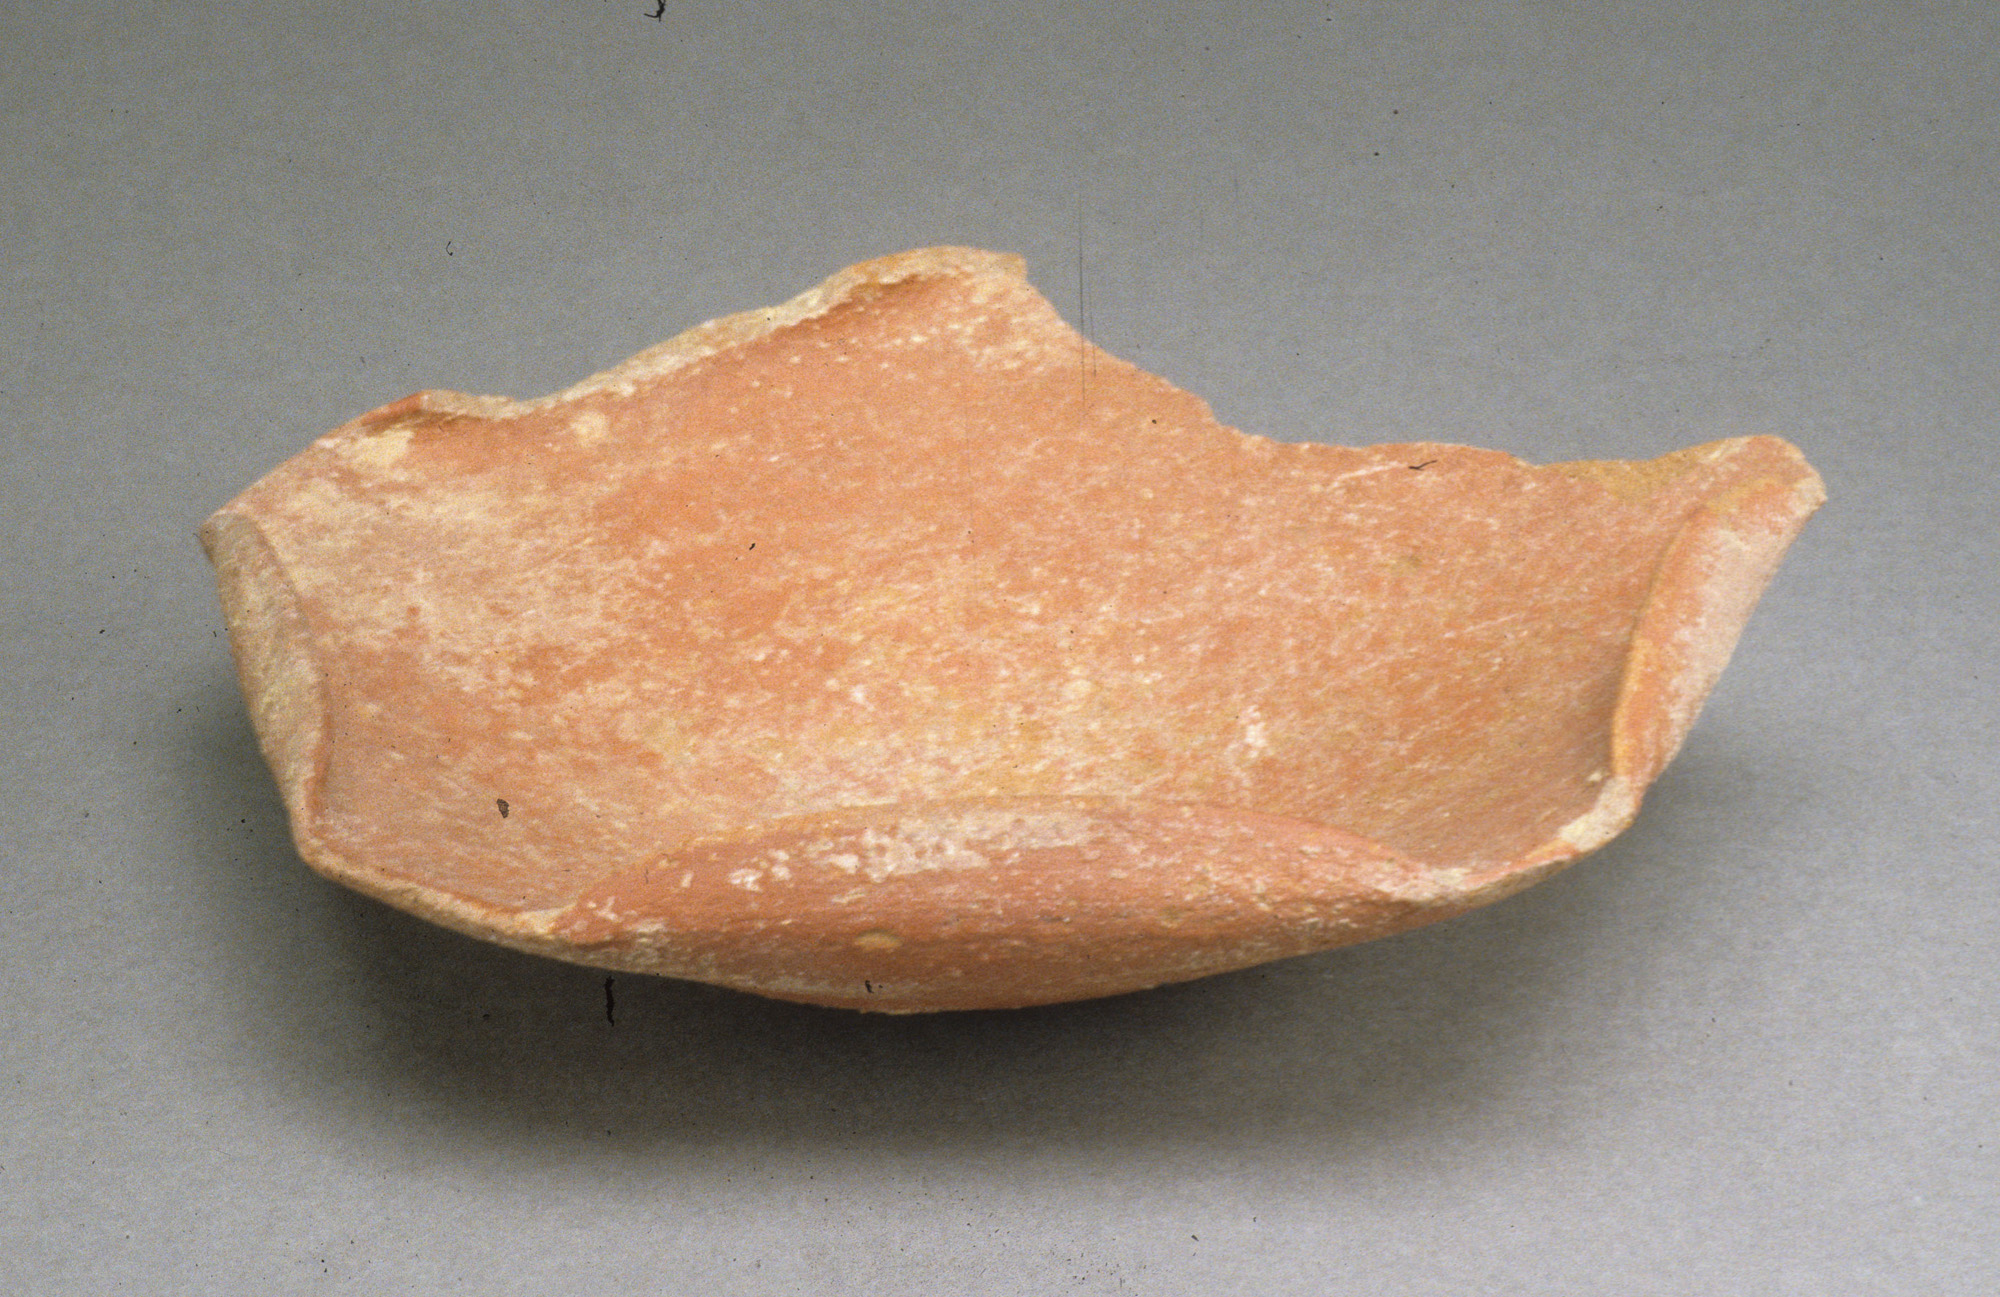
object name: dish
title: Dish with a folded rim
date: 2100-2010 BCE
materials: mineral, pottery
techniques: wash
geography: egypt